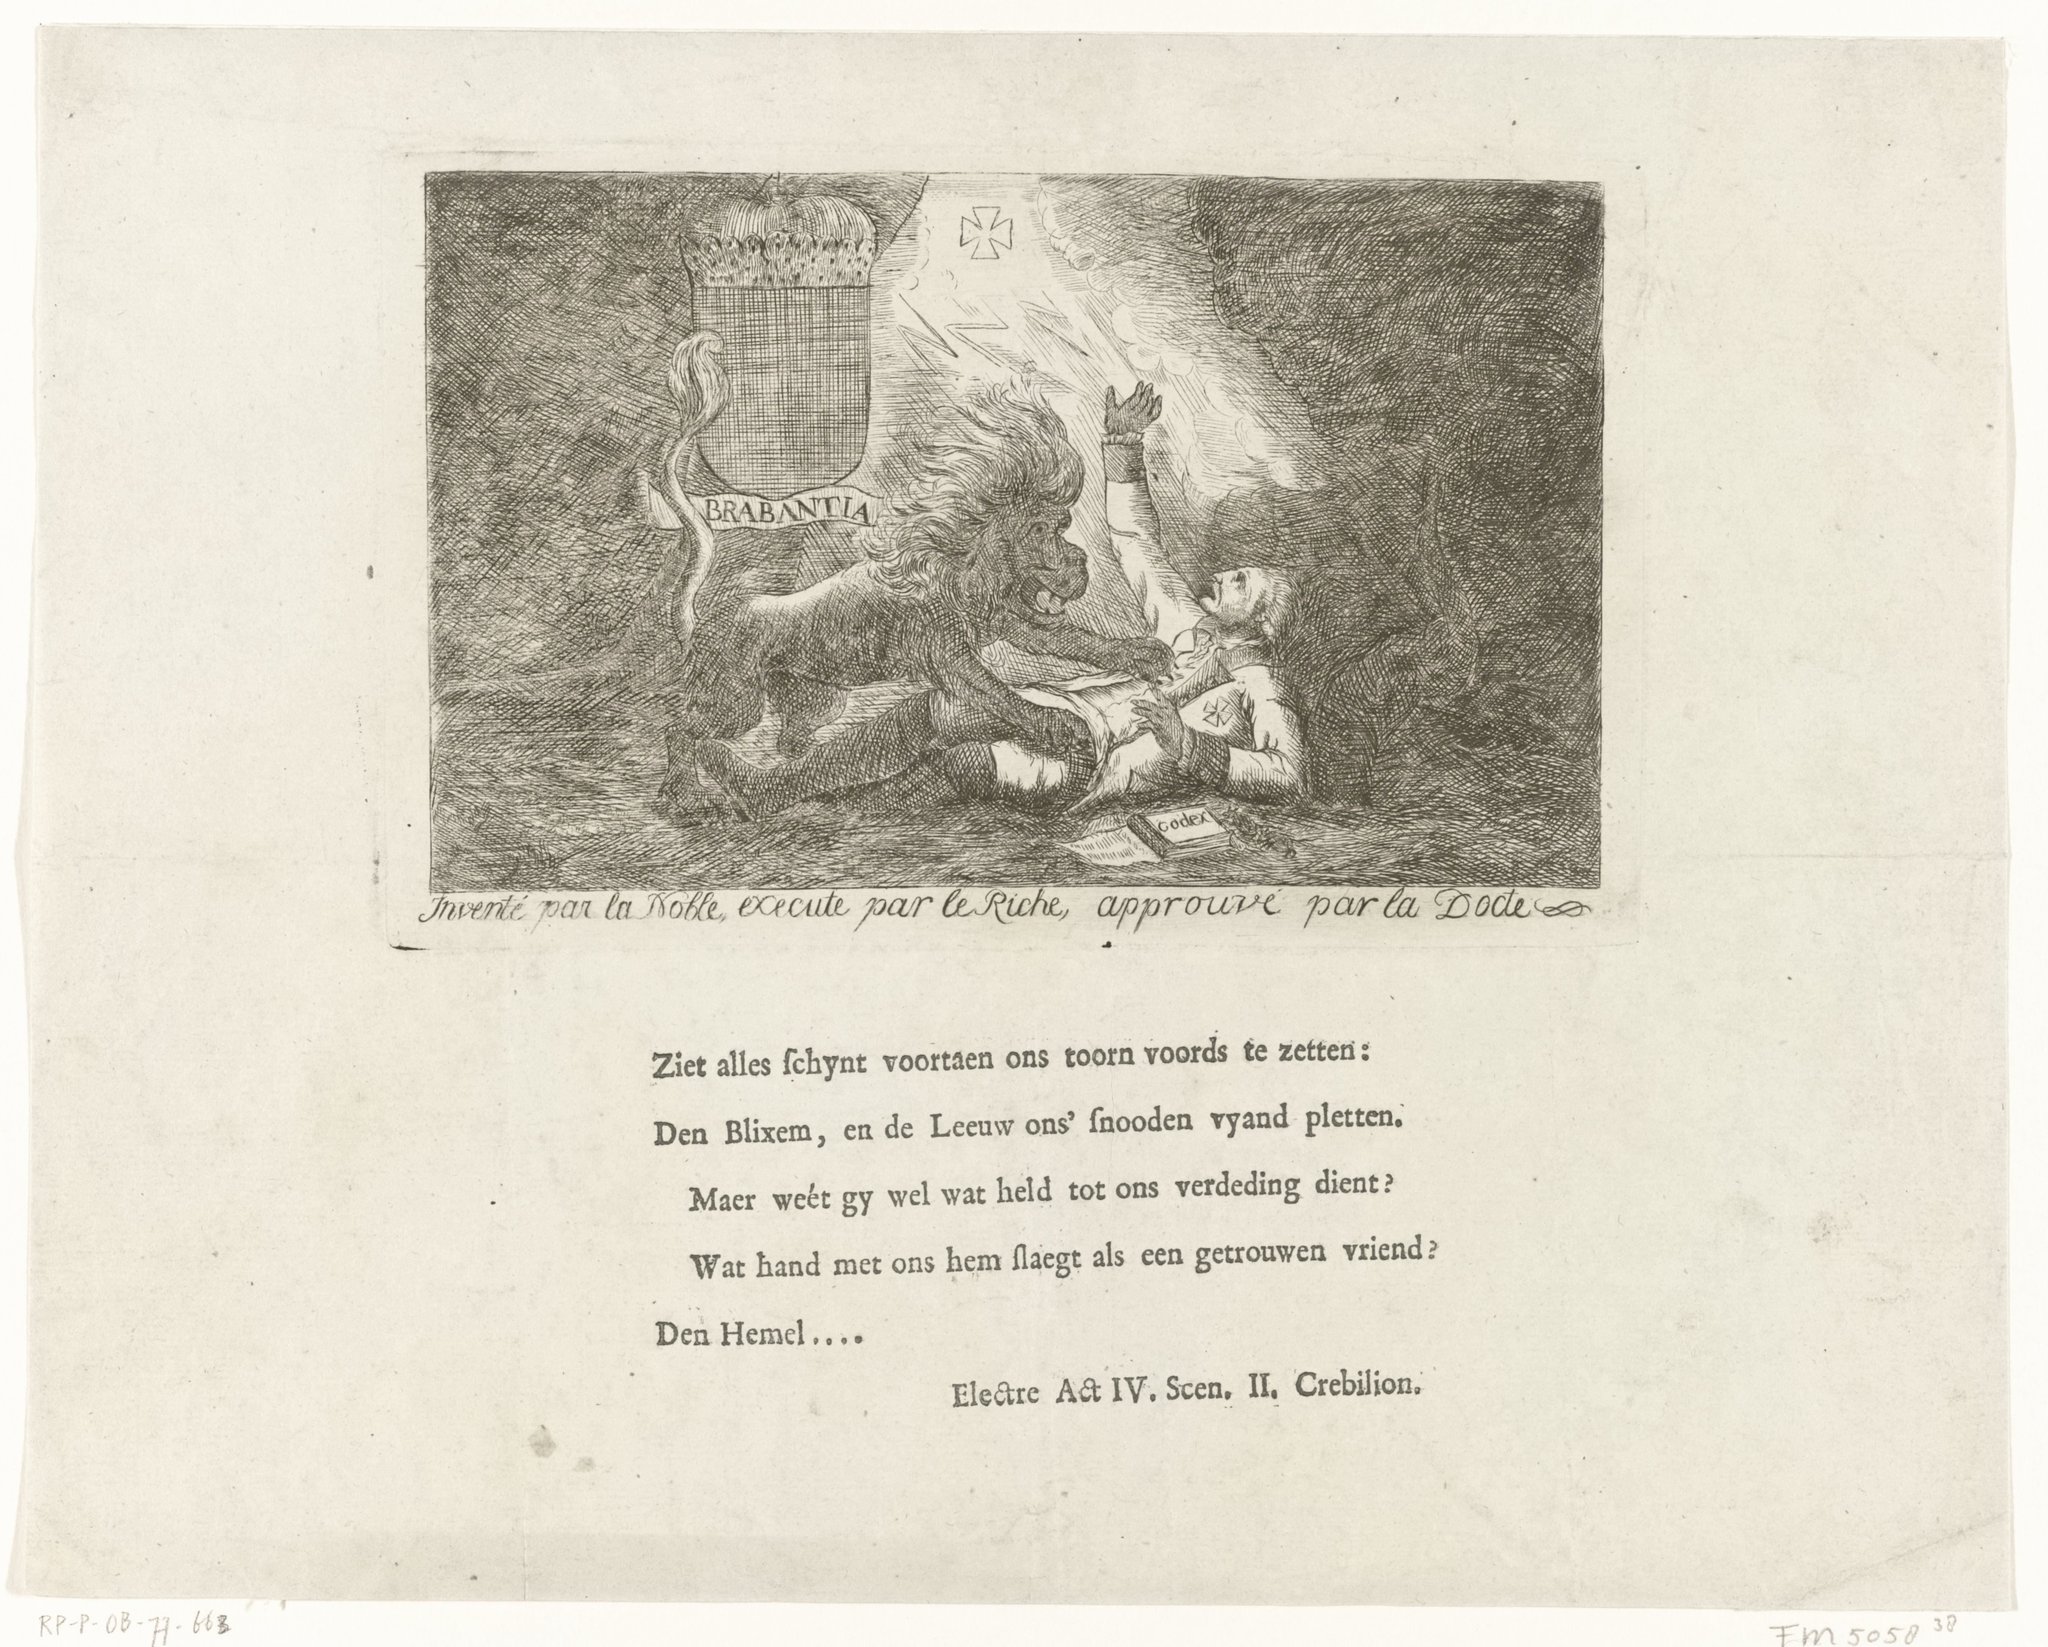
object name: print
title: Brabantse Omwenteling, 1787-1790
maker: Anonymous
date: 1787-1790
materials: paper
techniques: engraving, etching, letterpress printing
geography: southern netherlands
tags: jozef ii (duits keizer), beasts of prey, predatory animals: lion, brabant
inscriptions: collector's mark: Lugt 2228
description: De op de grond liggende Oostenrijkse keizer Jozef II wordt aangevallen door een woeste Brabantse leeuw. Met onderschrift van één regel. Op het blad onder de plaat een citaat van vijf regels uit het toneelstuk Electra in het Nederlands. Onderdeel van een grote groep van prenten betrekking hebbend op de gebeurtenissen van de Brabantse Omwenteling en de periode 1787-1790.